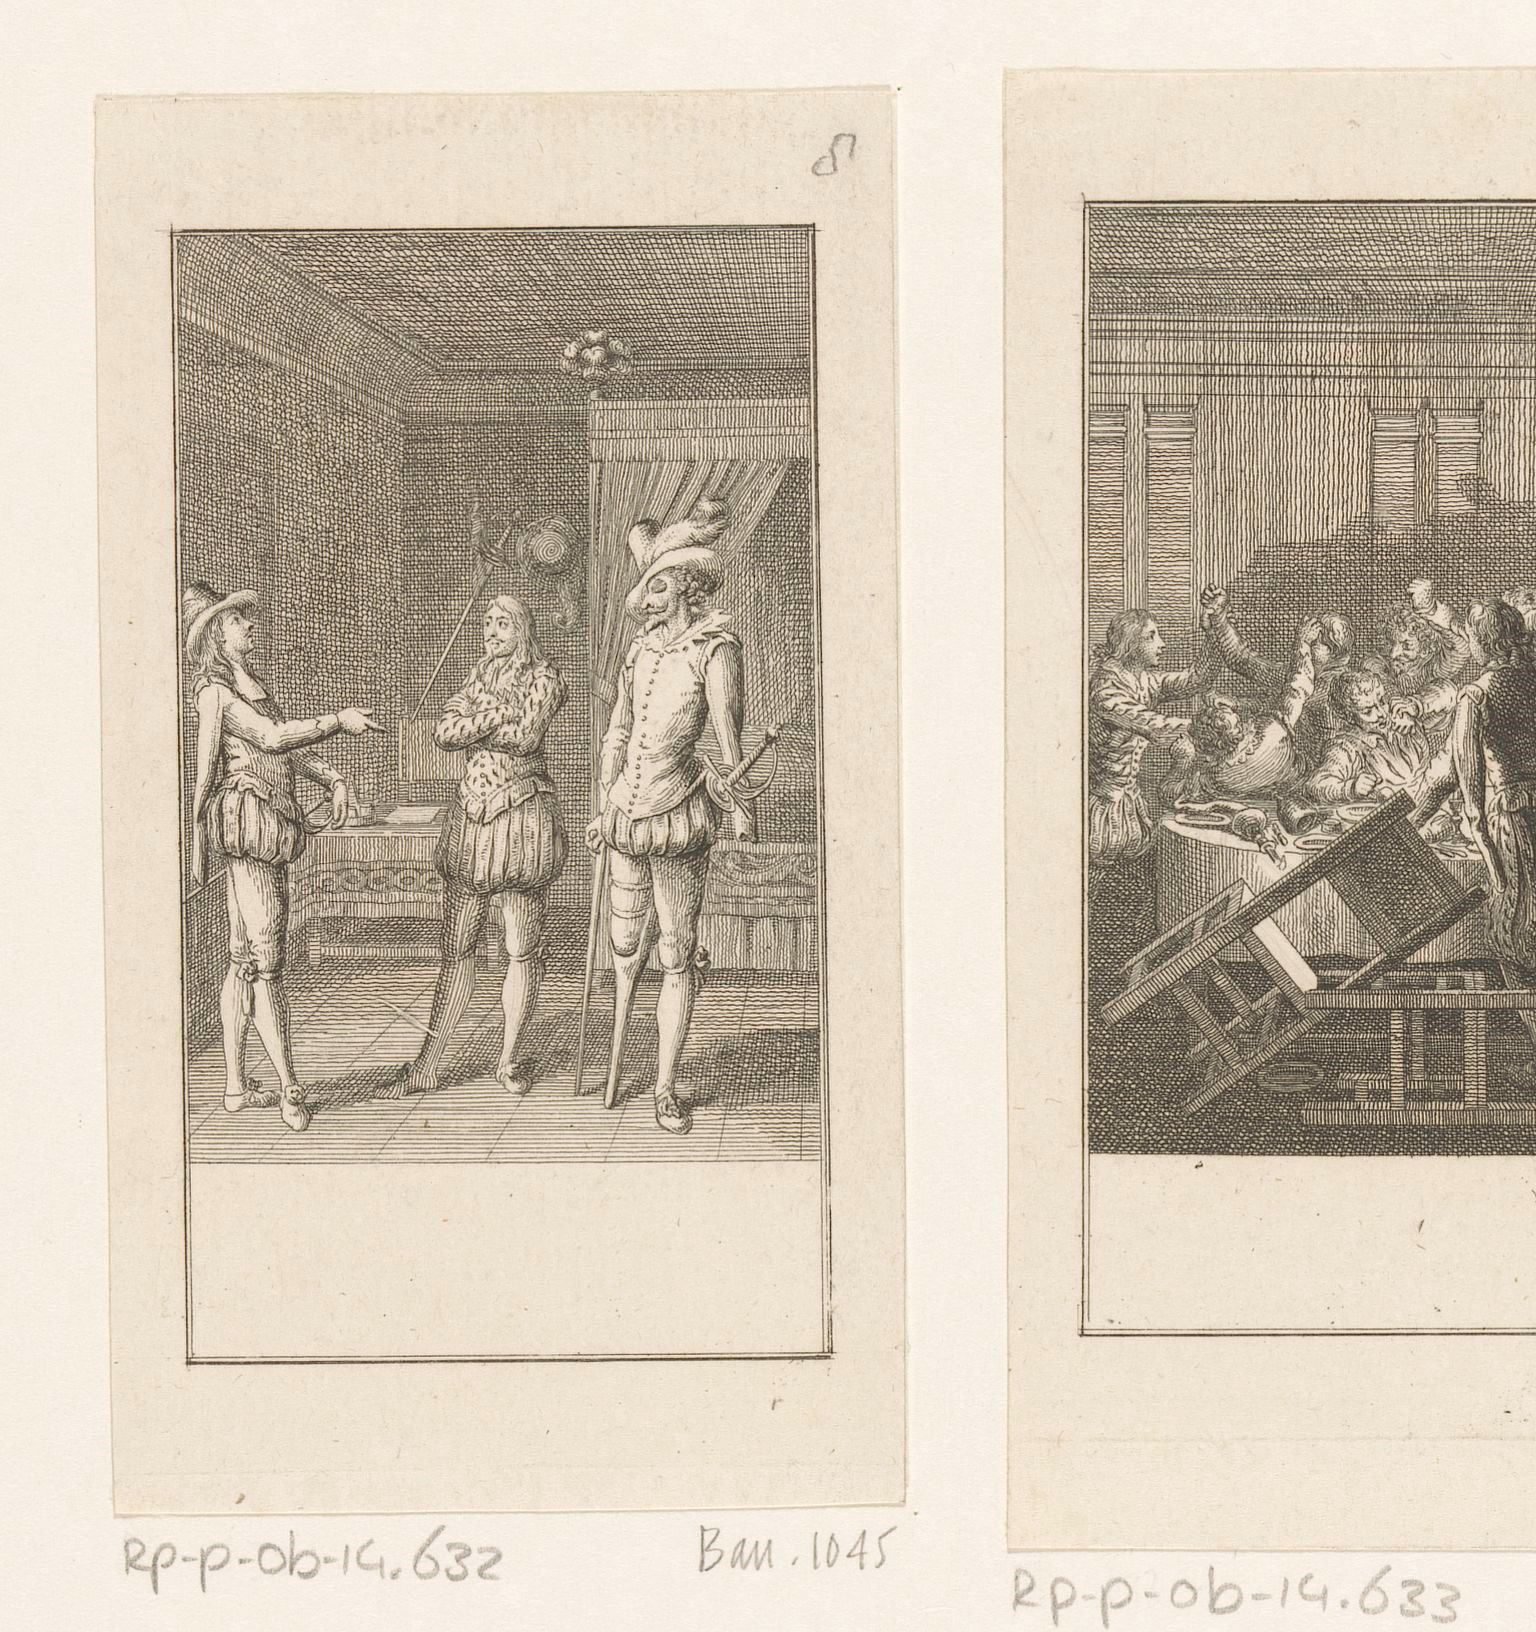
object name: print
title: Gil Blas in gesprek met Pedrillo en kapitein Don Annibal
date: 1783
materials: paper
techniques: etching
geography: berlin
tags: literature, wooden leg, interior of the house, conversation, dialogue; conversation piece, disabilities affecting the eyes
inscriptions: collector's mark: Lugt 2228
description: Vervaardigd voor 'Gil Blas de Santillane' van Alain-René Lesage. Een latere staat gebruikt in: Almanac de Gotha (...). Gotha: C. W. Ettinger, 1784.